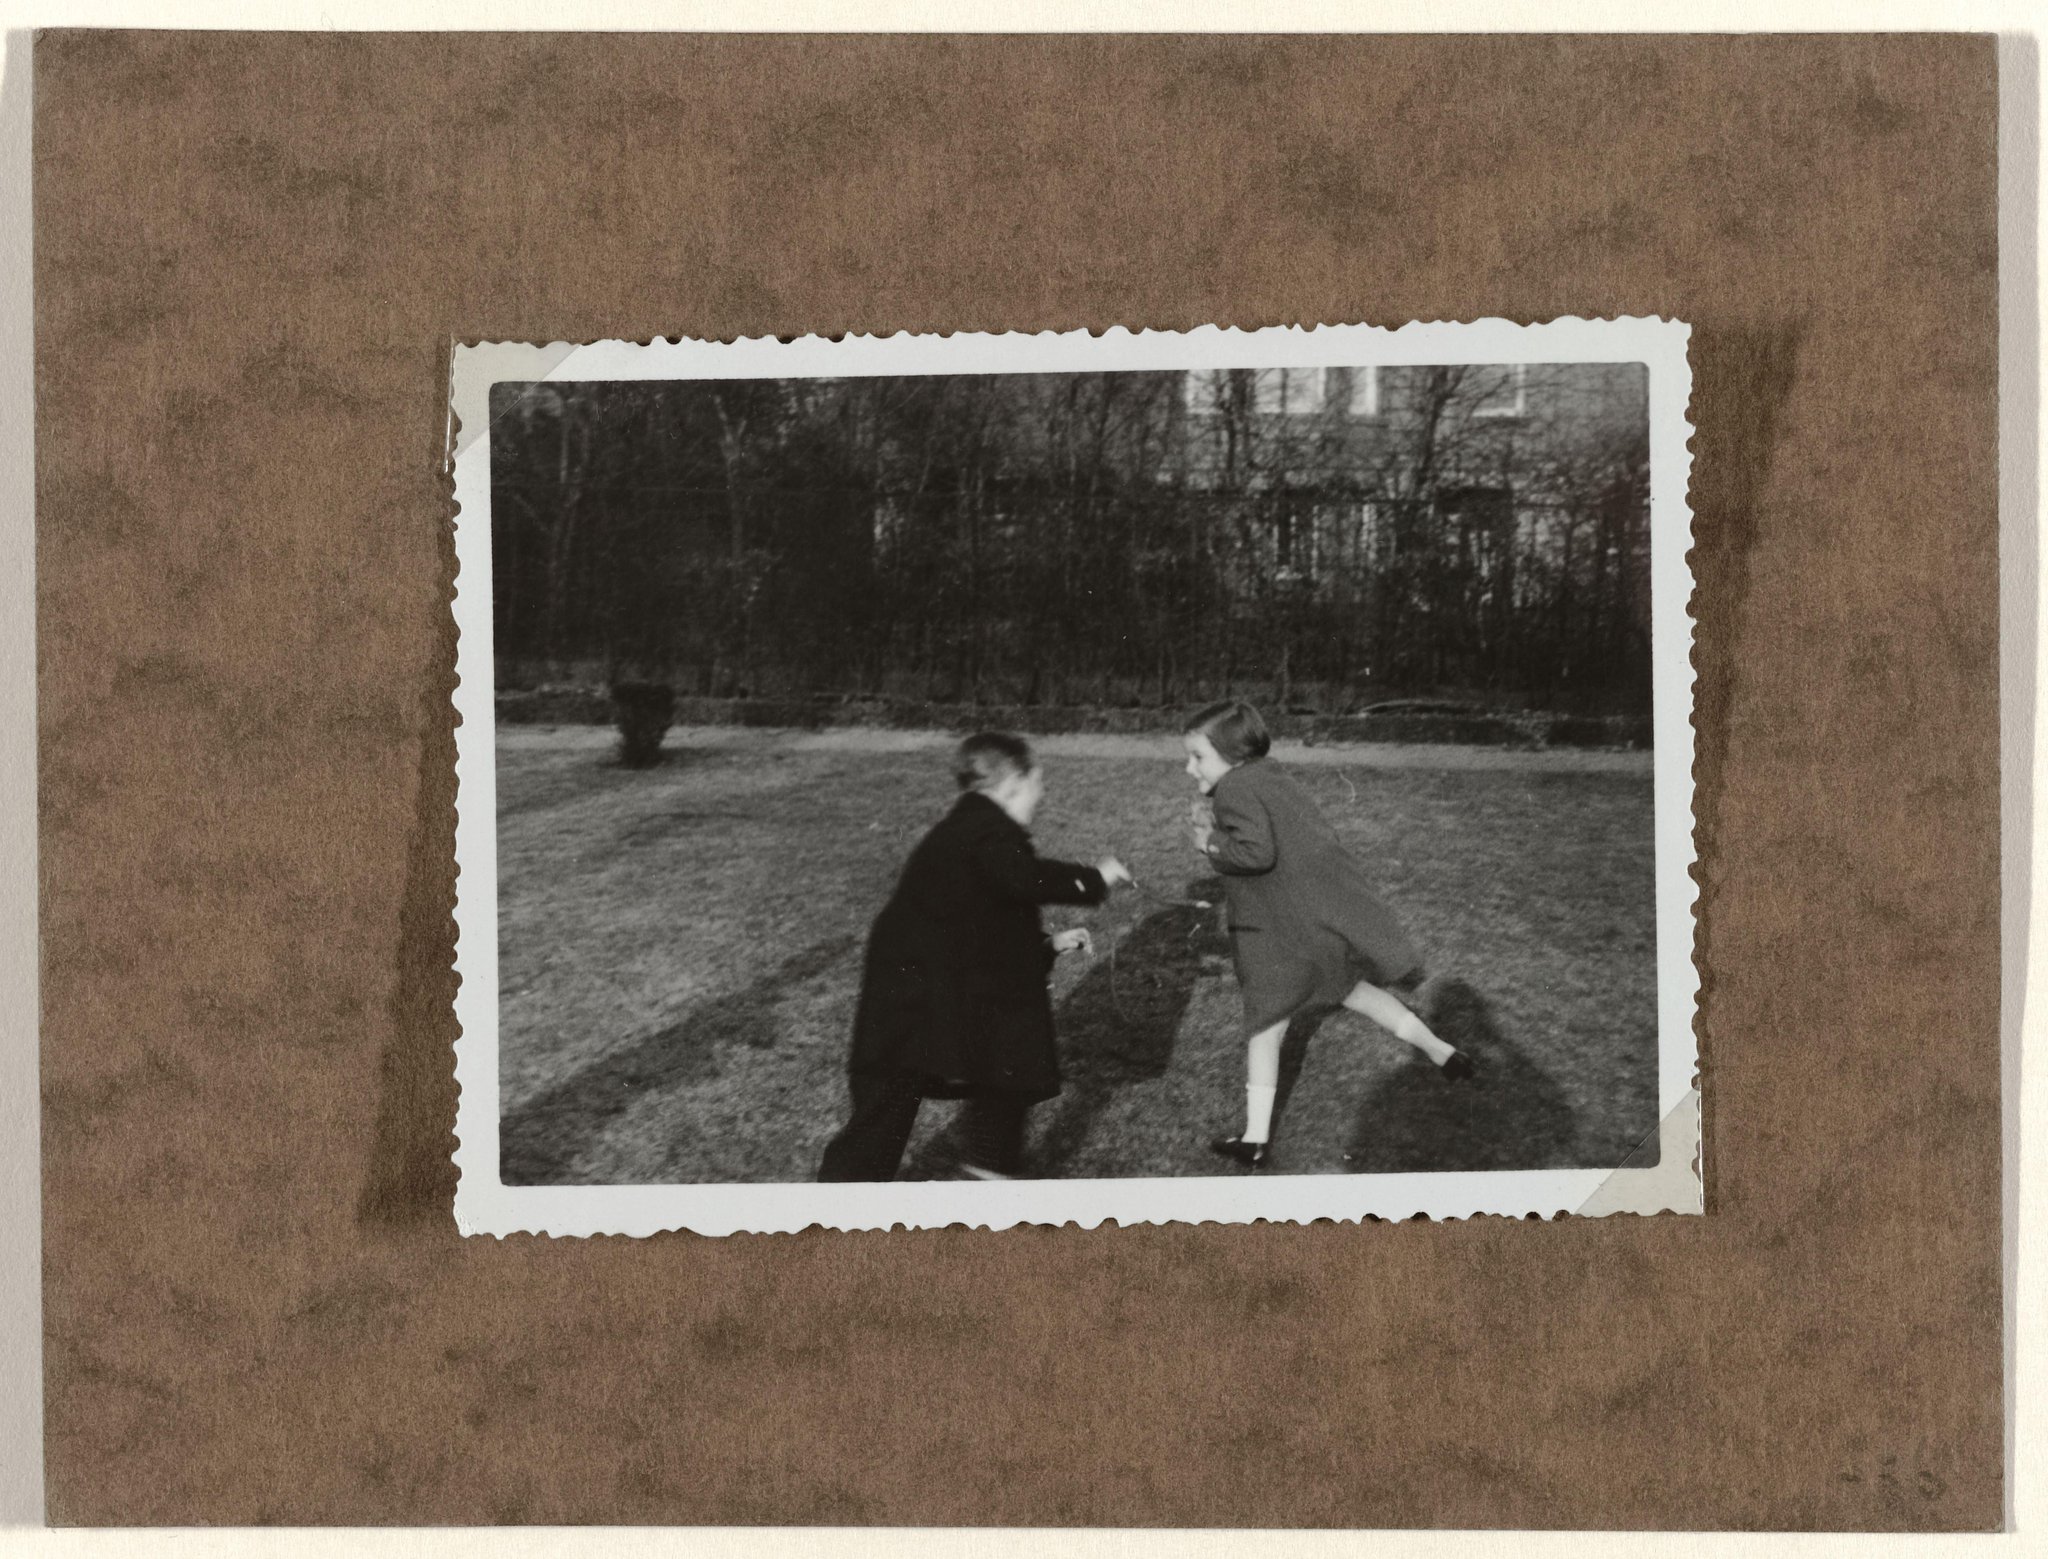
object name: photograph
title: Isabel Wachenheimer, Erica en Hansl in de tuin van de woning van Willy Moos in Hamburg, Bellevue 62, in maart-april 1935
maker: Anonymous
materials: photographic support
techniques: gelatin silver print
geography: hamburg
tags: leiden, isabel wachenheimer-elon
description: Dit object is onderdeel van de nalatenschap van Isabel Elon-Wachenheimer (1928-2010). Tot haar overlijden behoorde het samen met de andere objecten uit de nalatenschap tot haar privédomein van Isabel Wachenheimer. In die particuliere context zijn deze objecten tezamen en individueel aandenkens - aan de jeugd, ouders en familie van Isabel Wachenheimer vóór en tijdens de Shoah en aan haar leven na de Tweede Wereldoorlog. Isabel Wachenheimer, die van juni 1943 tot mei 1945 gevangen zat in Kamp Westerbork, Theresienstadt, Auschwitz, Lenzing a/d Oberdonau (een buitenkamp van Mauthausen), overleefde de Shoah. Haar ouders – Eugène Wachenheimer en Else Wachenheimer-Moos - werden op 14 oktober 1944 in Auschwitz-Birkenau vermoord.